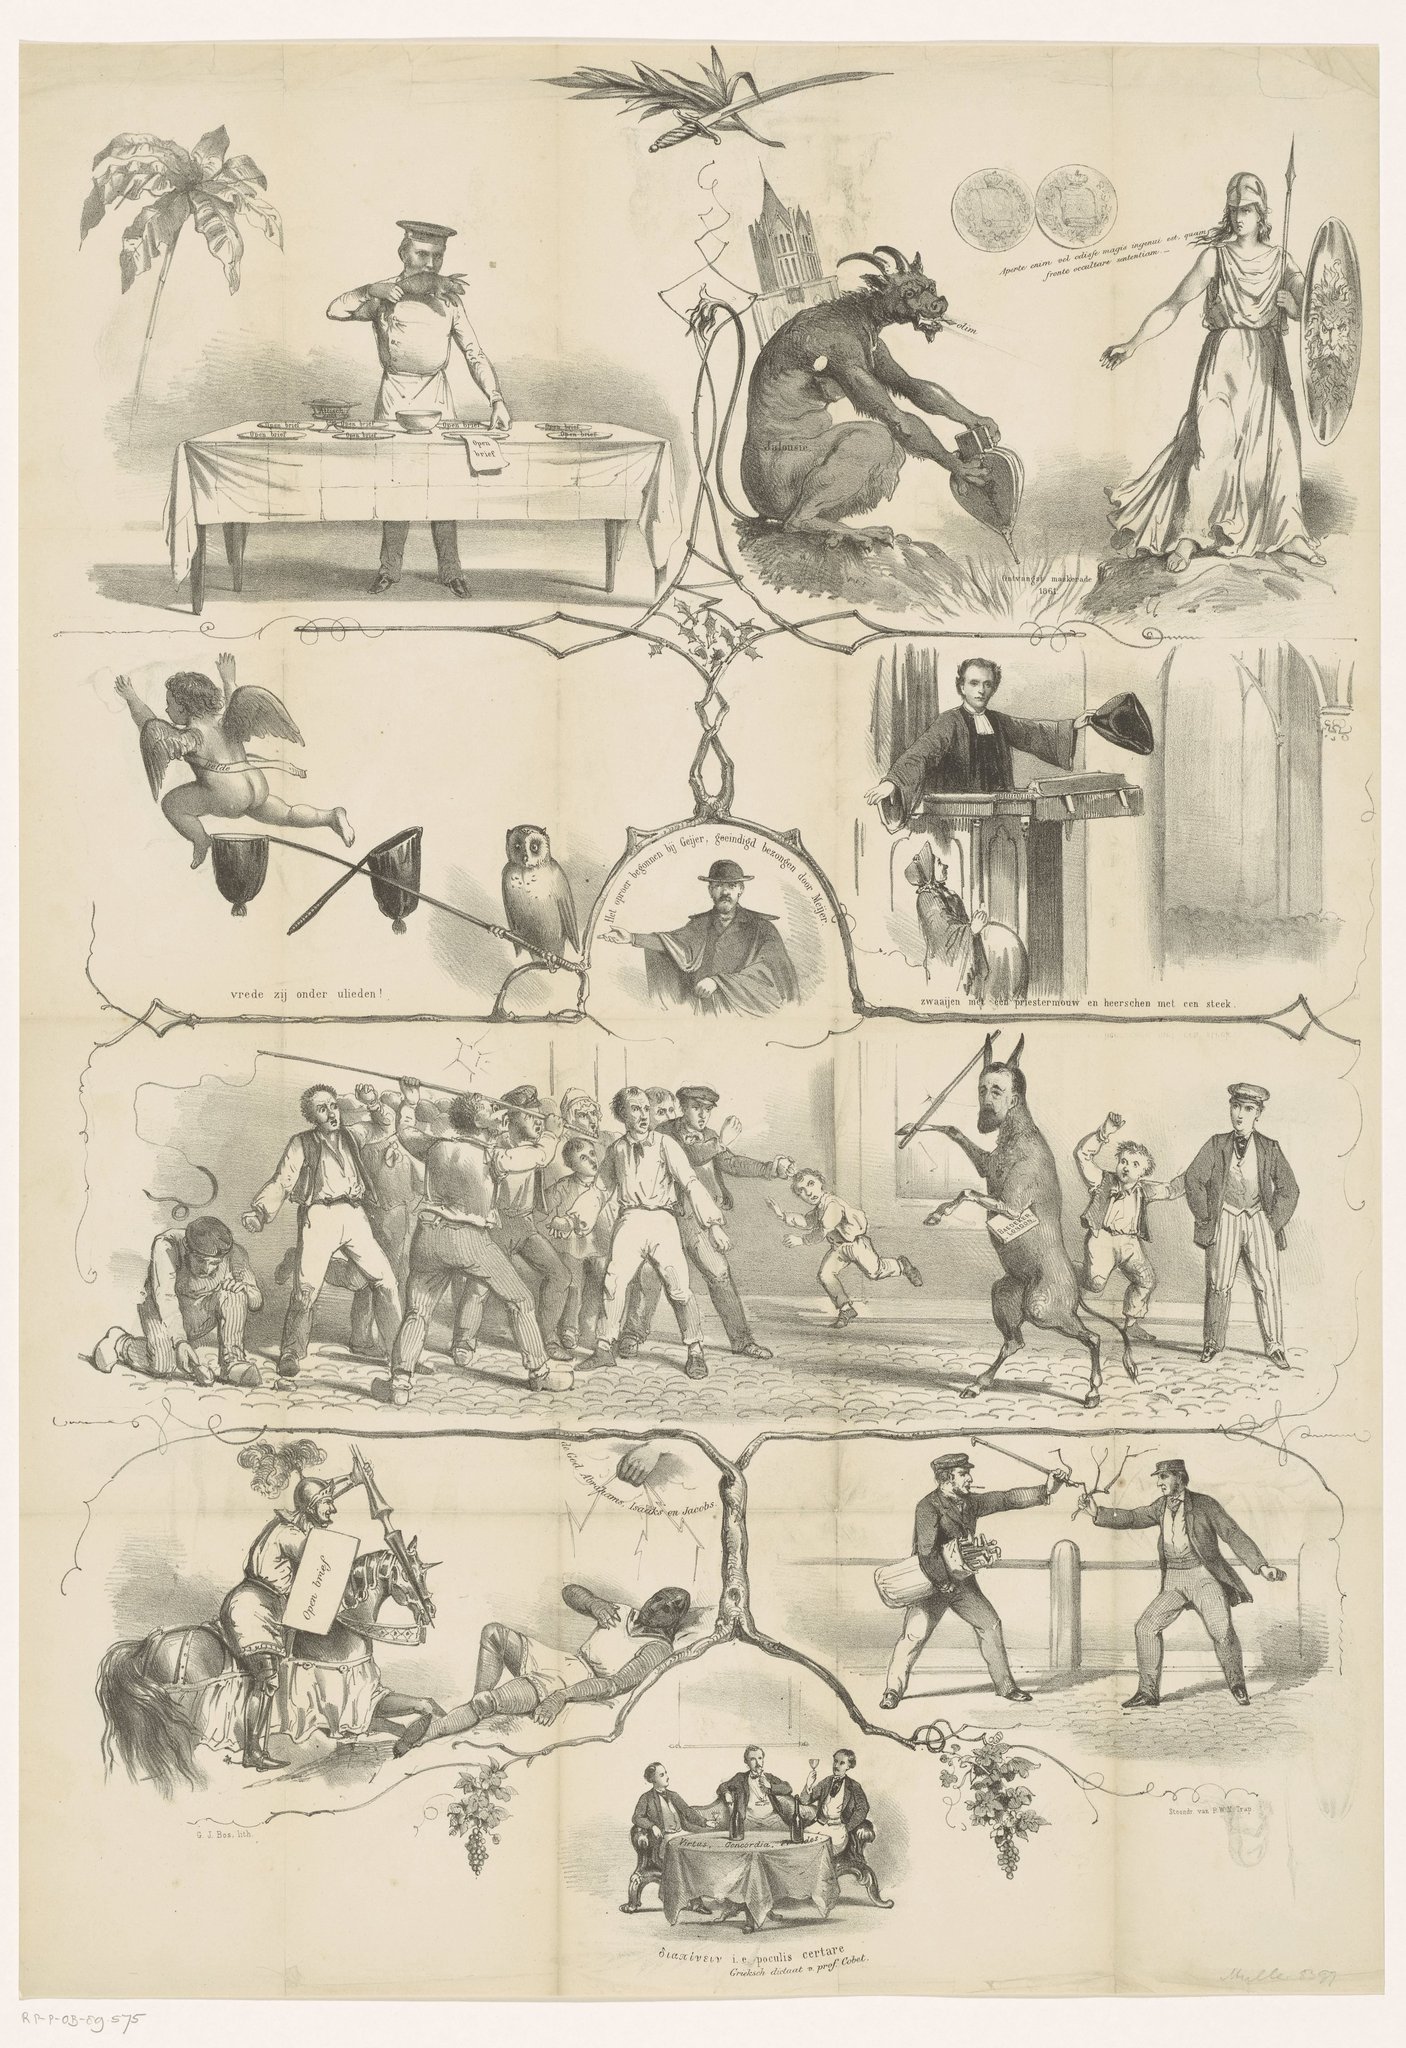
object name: print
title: Voorstellingen uit de geschiedenis van het Leidse studentencorps, 1863-1864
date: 1863-1864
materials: paper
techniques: lithograph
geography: leiden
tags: students' organization, leiden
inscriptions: collector's mark: Lugt 2228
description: Blad met acht voorstellingen uit de geschiedenis van het studentencorps van de Hogeschool van Leiden, 1863-1864. De afzonderlijke scènes gescheiden door takken en ranken. Met een duivel, verschillende hoogleraren (Cobet, Van Gorkum, Goudsmit, Van der Brugghen), een uil en ridders. Onderaan drie studenten wijn drinkend rond een tafel.